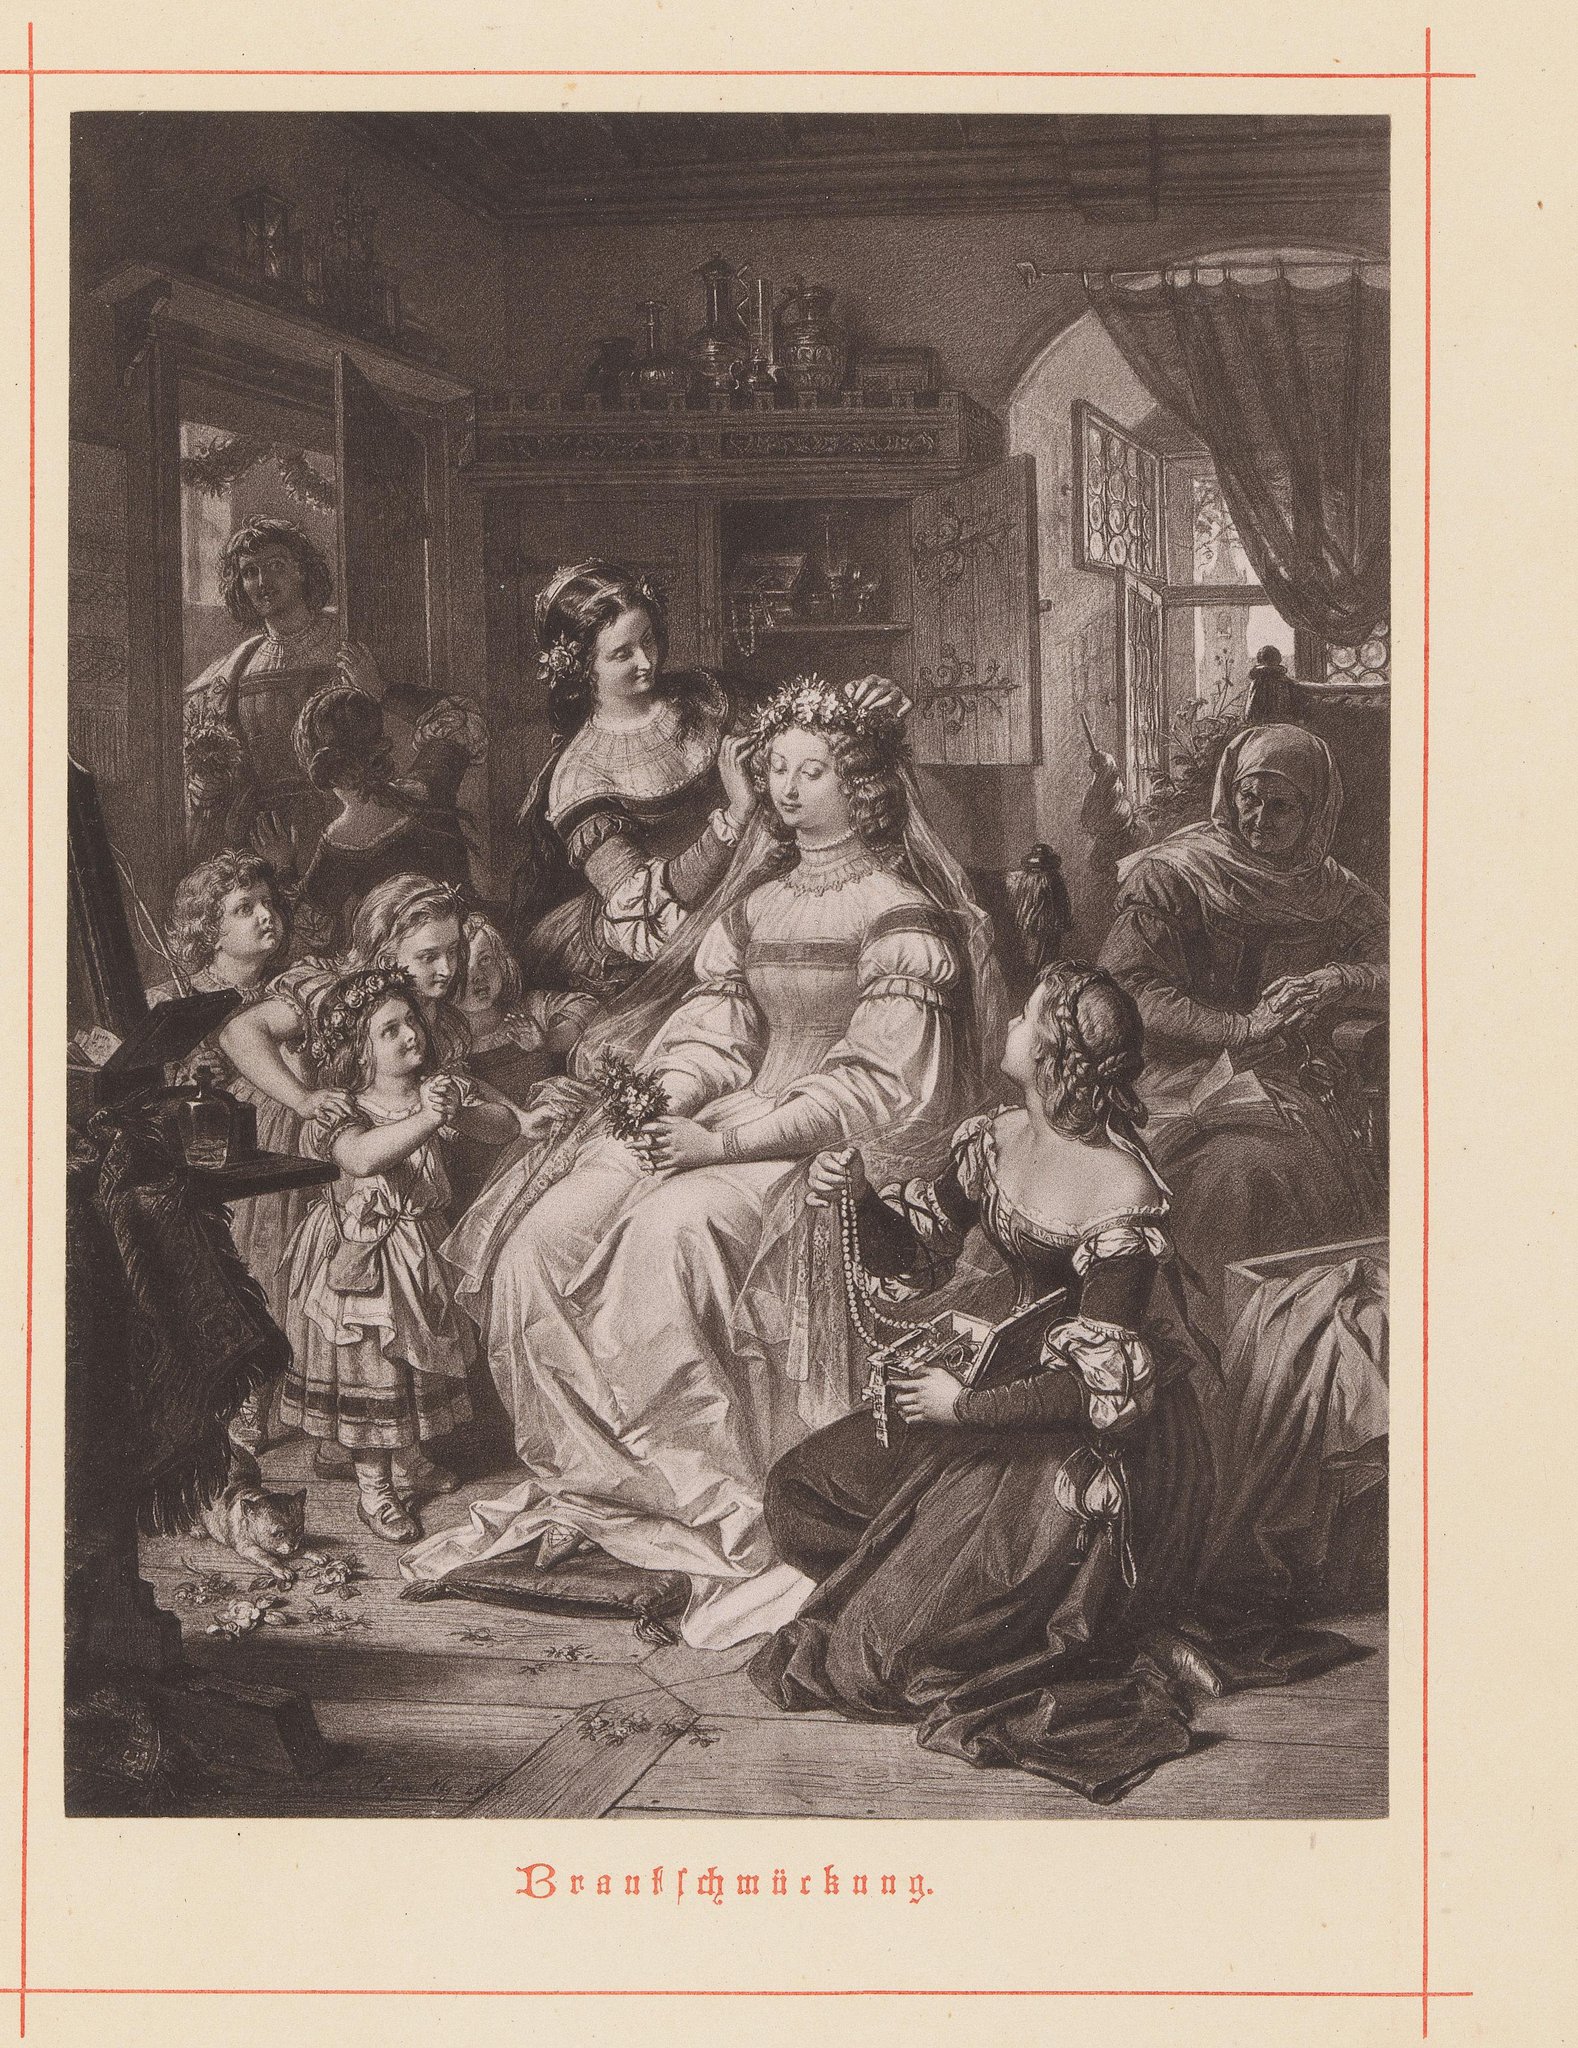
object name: page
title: Fotoreproductie van een tekening van een bruid die wordt aangekleed door vrouwen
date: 1871-1881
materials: paper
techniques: photograph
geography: germany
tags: dressing the bride